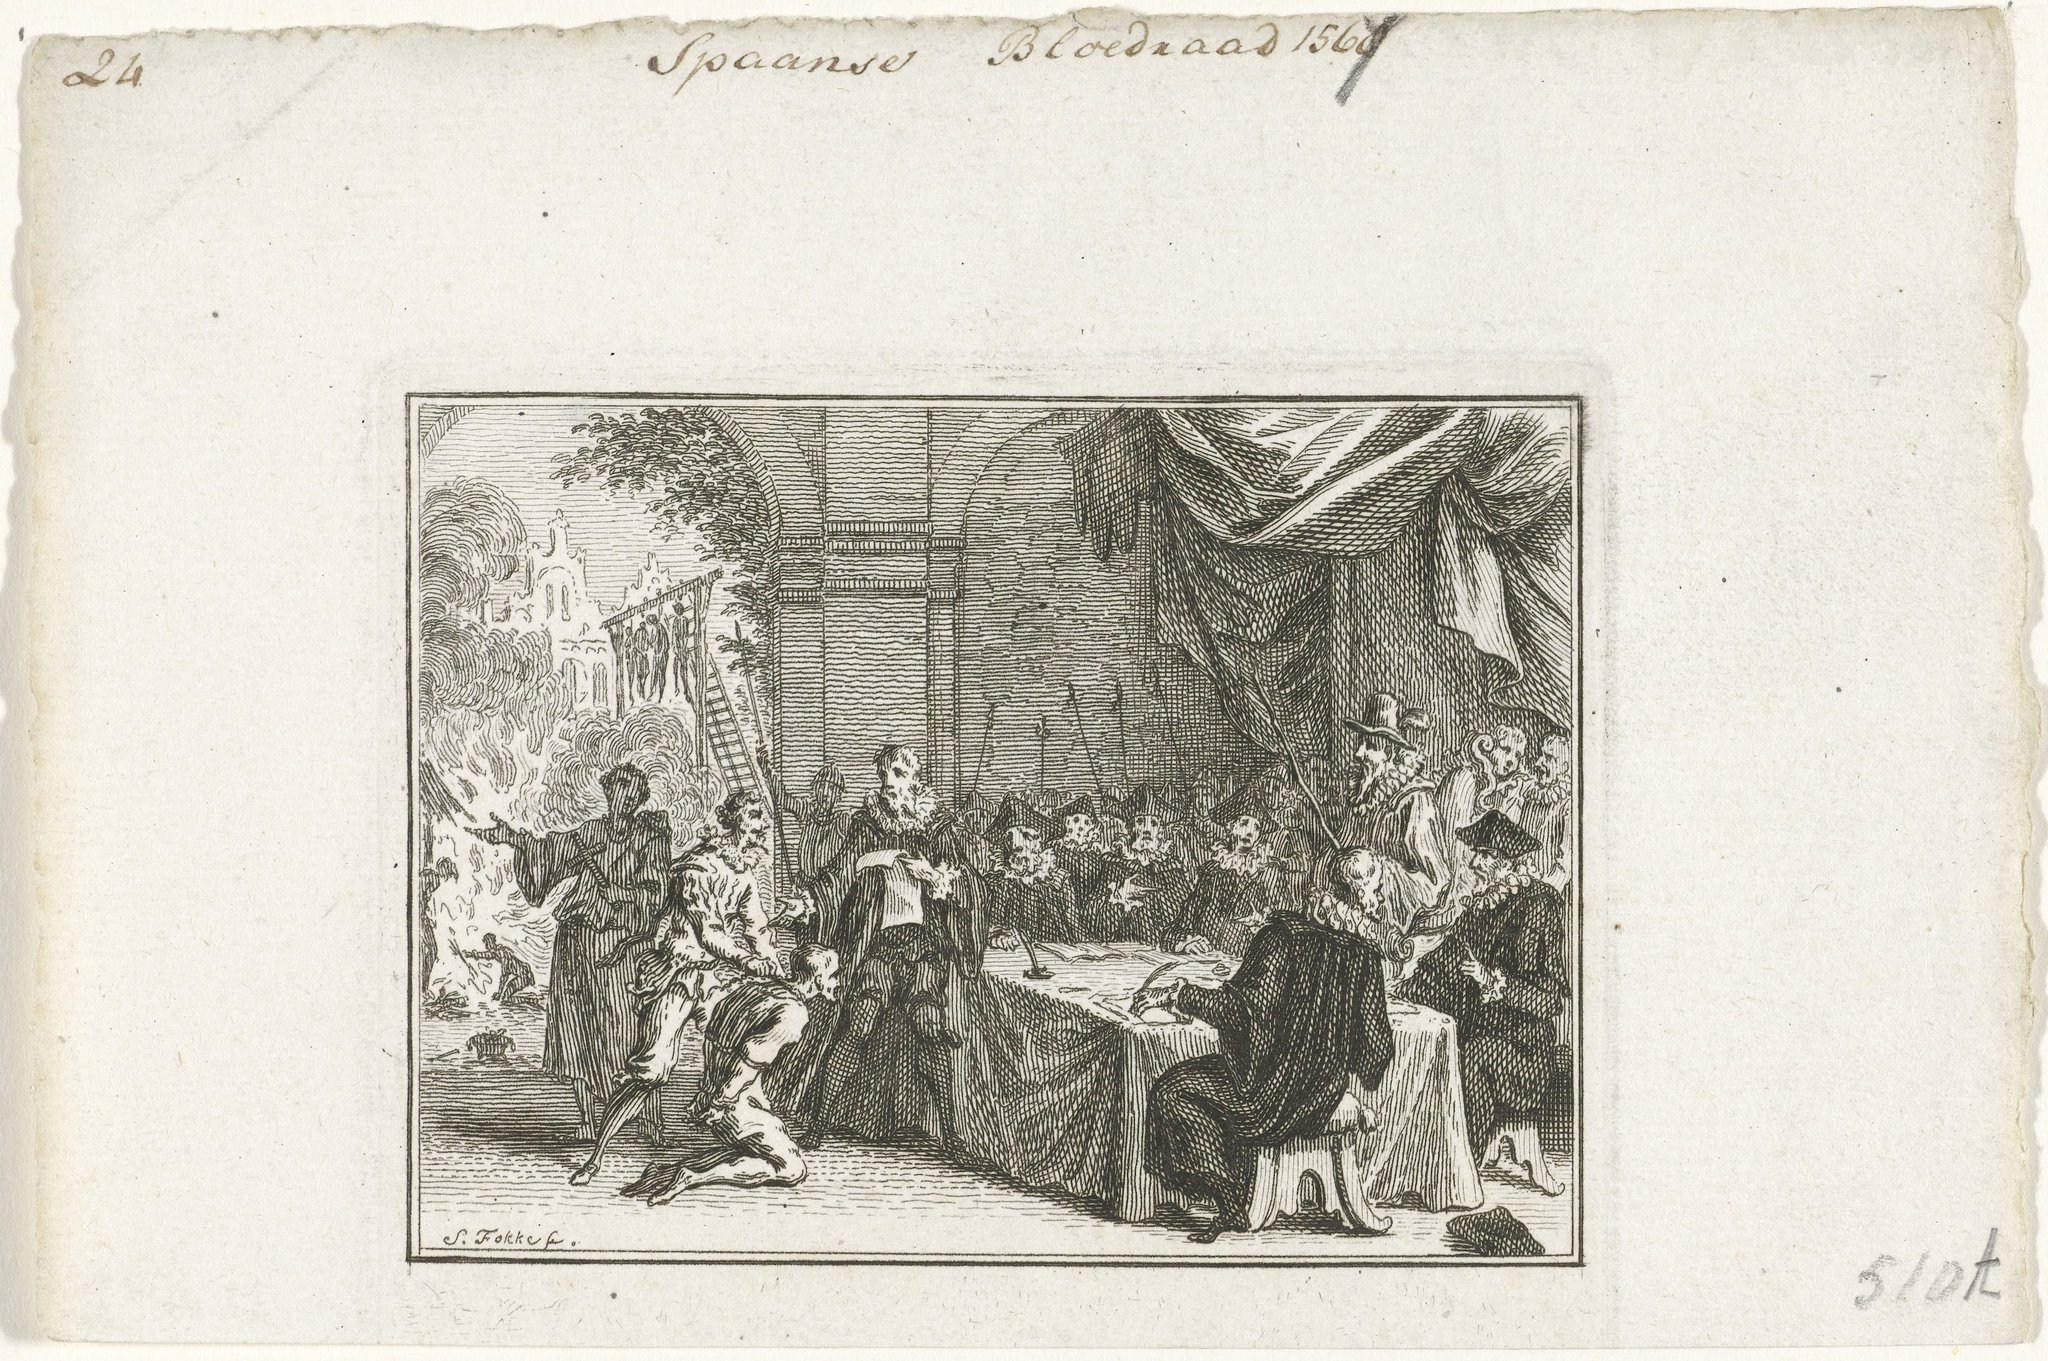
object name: history print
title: Gevangene voor de Spaanse Bloedraad, 1567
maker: simon fokke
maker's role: draughtsman, print maker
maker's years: 1712-1784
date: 1722-1750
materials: paper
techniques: etching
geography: northern netherlands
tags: fernando álvarez de toledo (3rd duke of alba), violent death by hanging, violent death by burning at the stake; pyre, court session (court of justice)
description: Illustratie voor: J.W. te Water, De vaderlandsche Historie van den heere J. Wagenaar, verkort, en met leerzaame aanmerkingen, ten dienste der Nederlandsche jeugd, 1784-1800, 4 delen. Niet in Frederik Muller; door het RPK toegevoegd nummer. Staat vóór de letter.